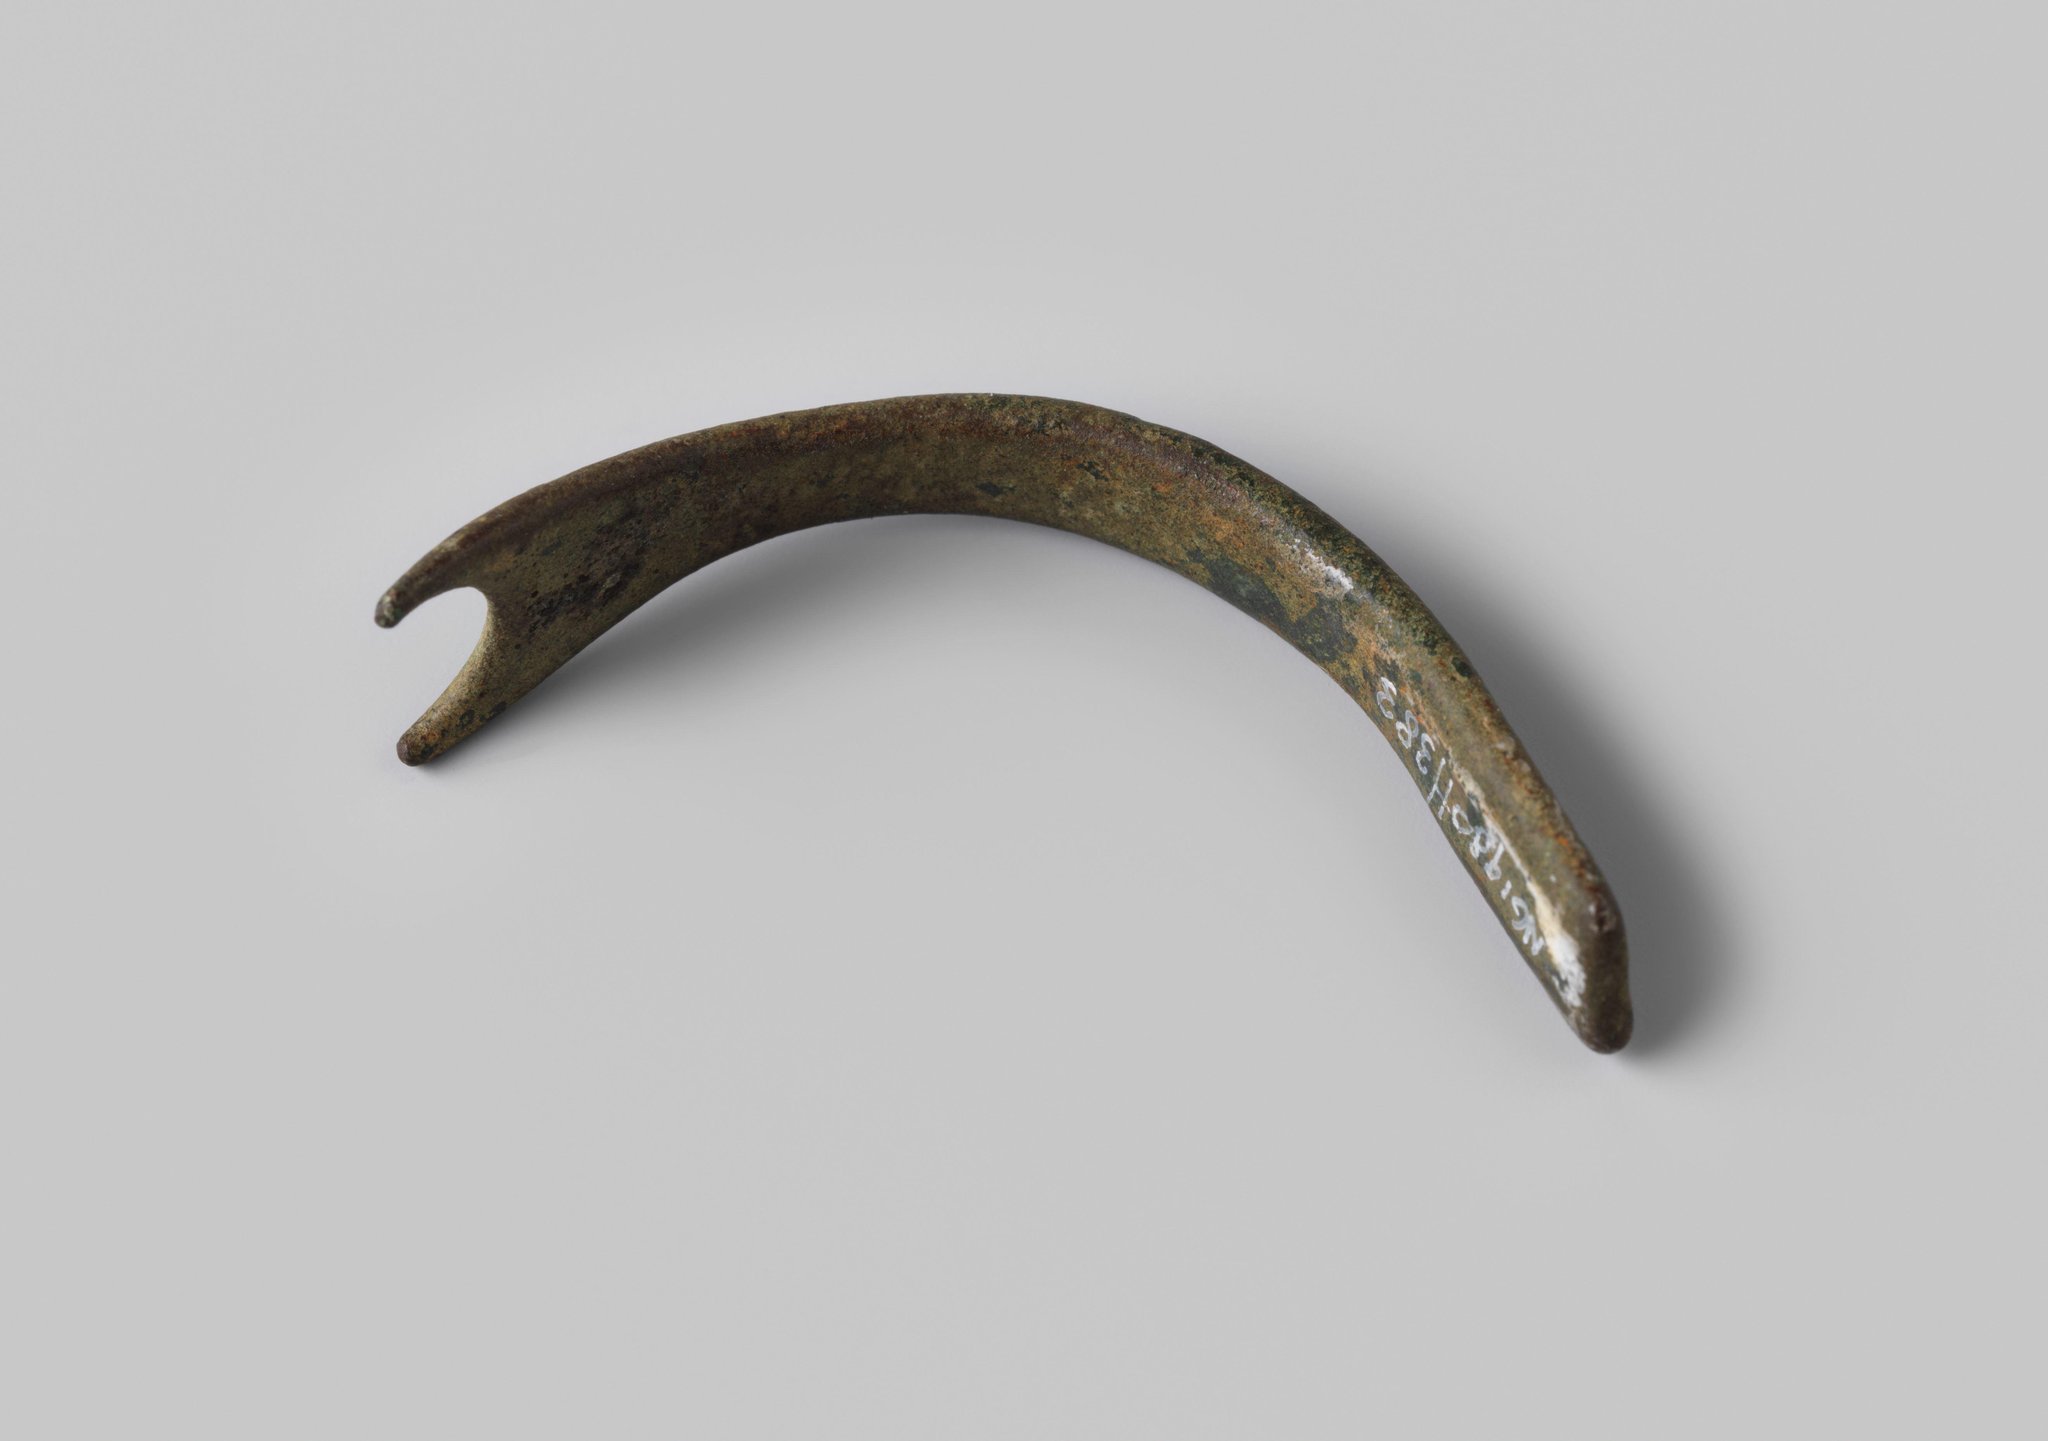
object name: fragment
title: Fragment van koper uit het wrak van de Oost-Indiëvaarder Hollandia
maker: Anonymous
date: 1700-1743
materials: copper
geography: netherlands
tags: verenigde oostindische compagnie, hollandia (schip), annet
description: Varied parts or fragments, strips and strip-shaped fragments; fragm.